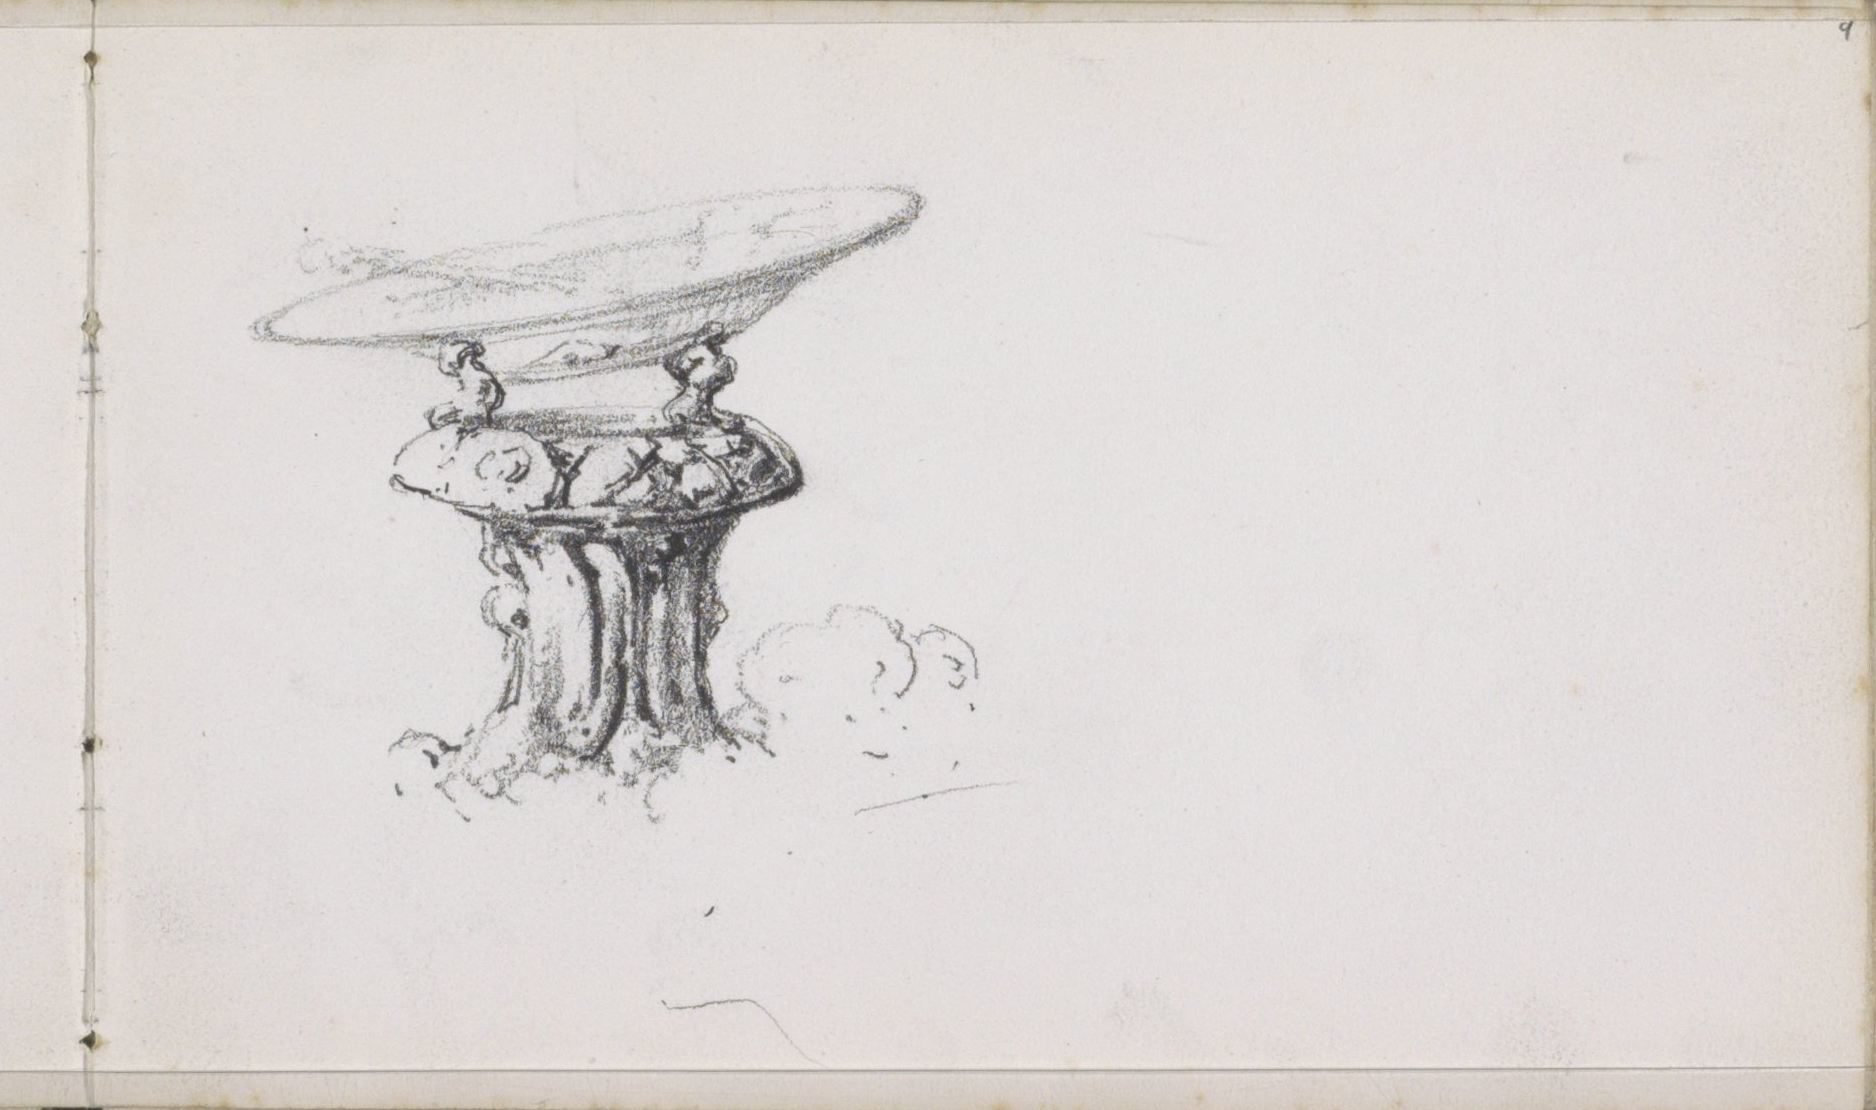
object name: sketchbook leaf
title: Schaal op een ornamentele sokkel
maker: maria vos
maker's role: draughtsman, painter, print maker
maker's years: 1824-1906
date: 1811-1867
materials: paper, pencil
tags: ornament derived from architectural details, dish, plate, saucer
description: Blad 9 recto uit een schetsboek met 40 bladen.